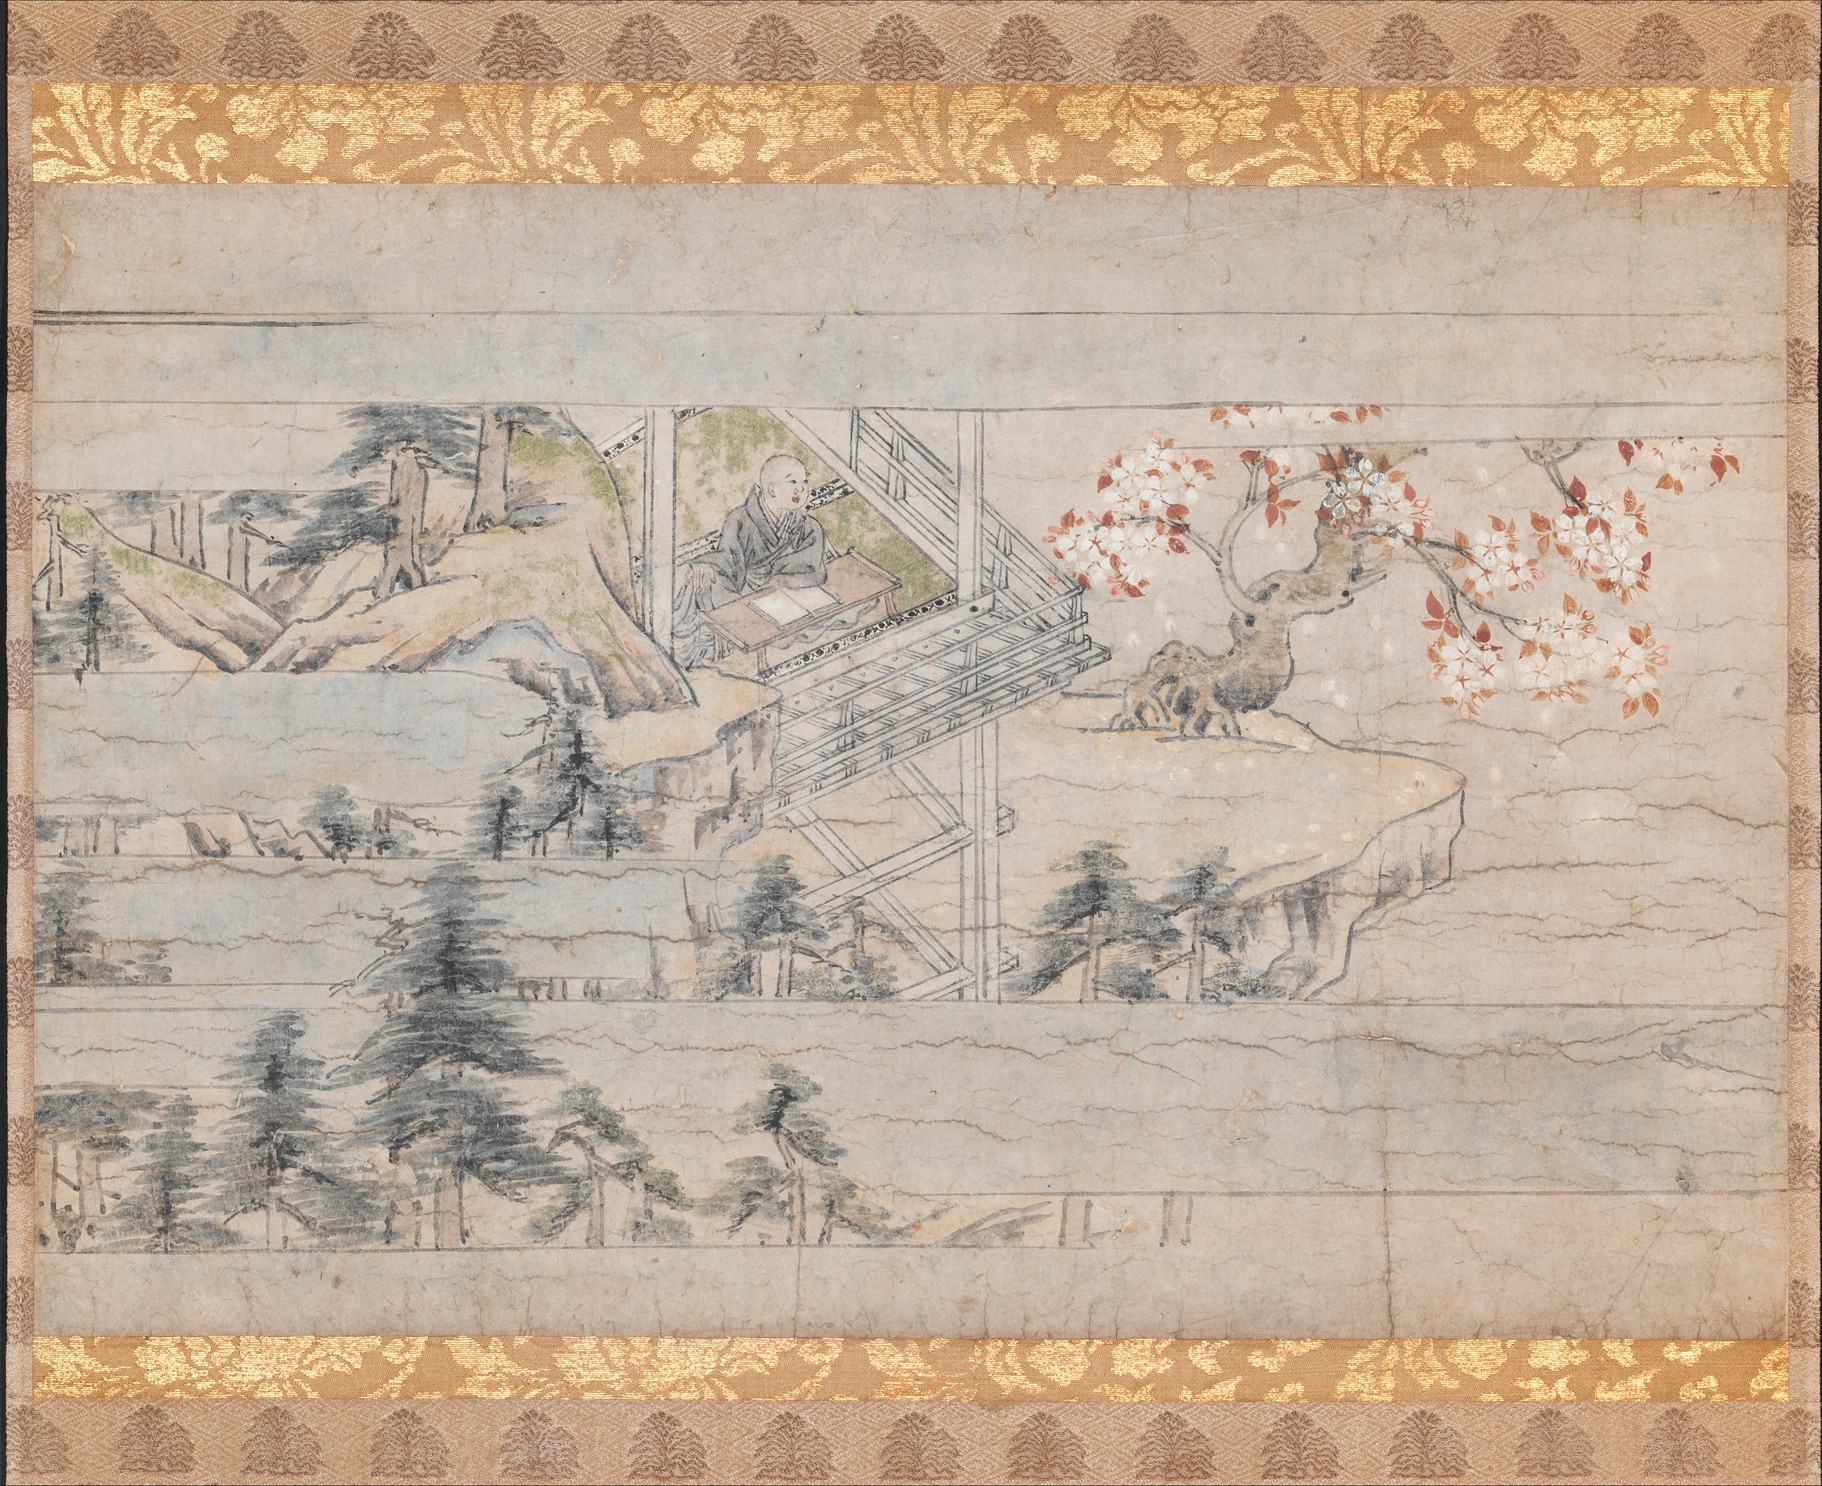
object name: hanging scroll section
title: Detached section from scroll one from A Long Tale for an Autumn Night (Aki no yo no nagamonogatari), now remounted in original position as part of 2002.459.1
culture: japanese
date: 1400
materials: gold, ink, paper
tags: men,monks